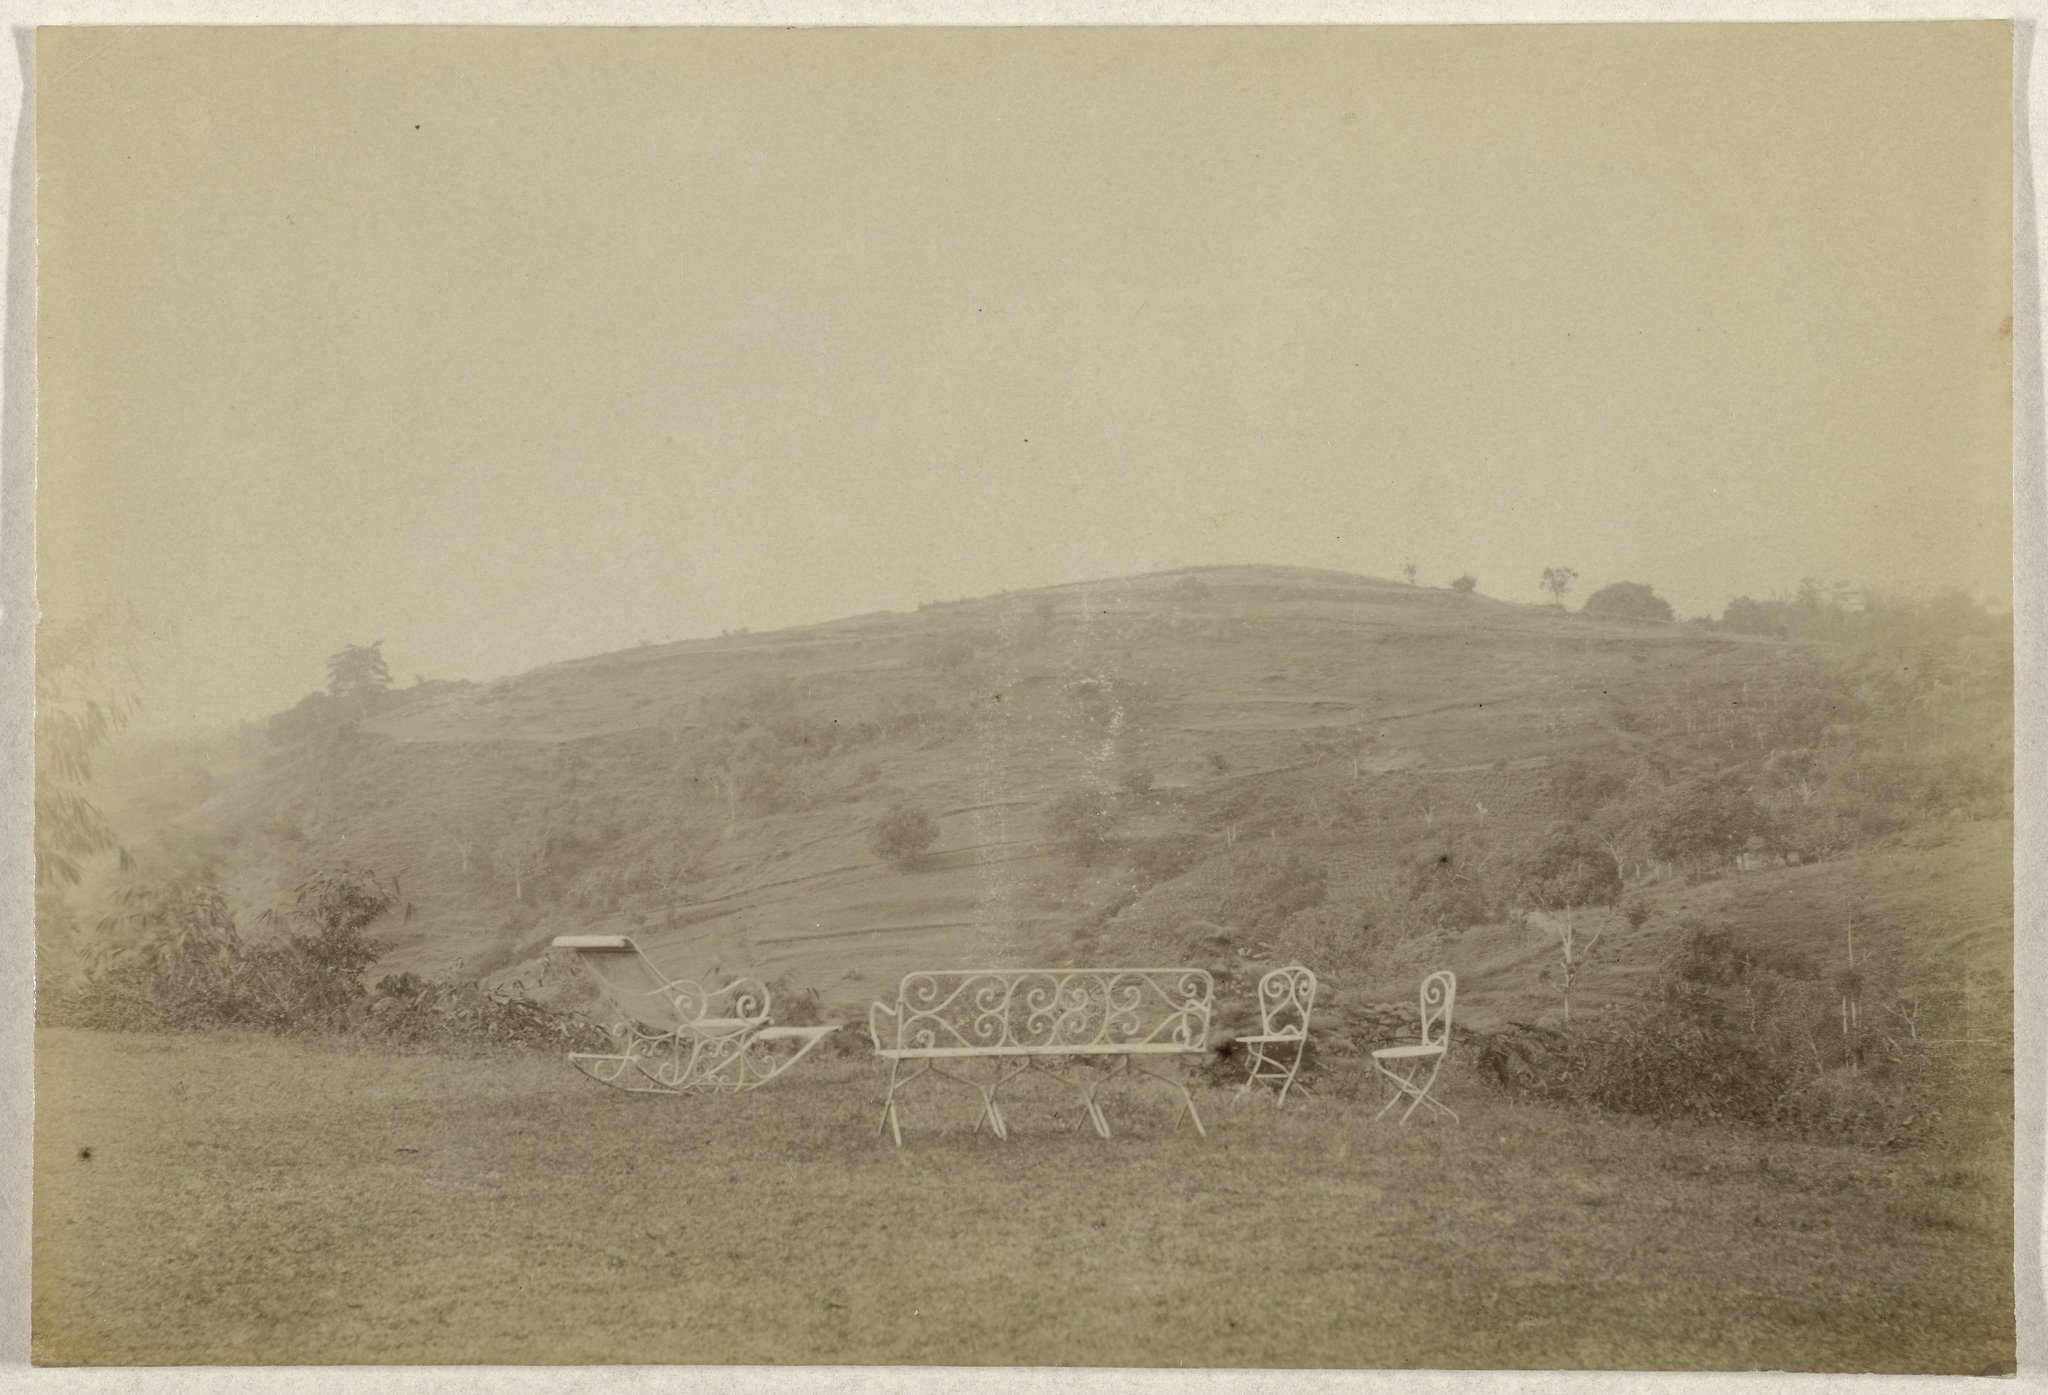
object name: photograph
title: Tuinmeubilair in een heuvellandschap in Nederlands-Indië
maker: Anonymous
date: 1870-1900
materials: paper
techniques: albumen print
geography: indonesia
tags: seating furniture, landscapes in tropical and sub-tropical regions, indonesia